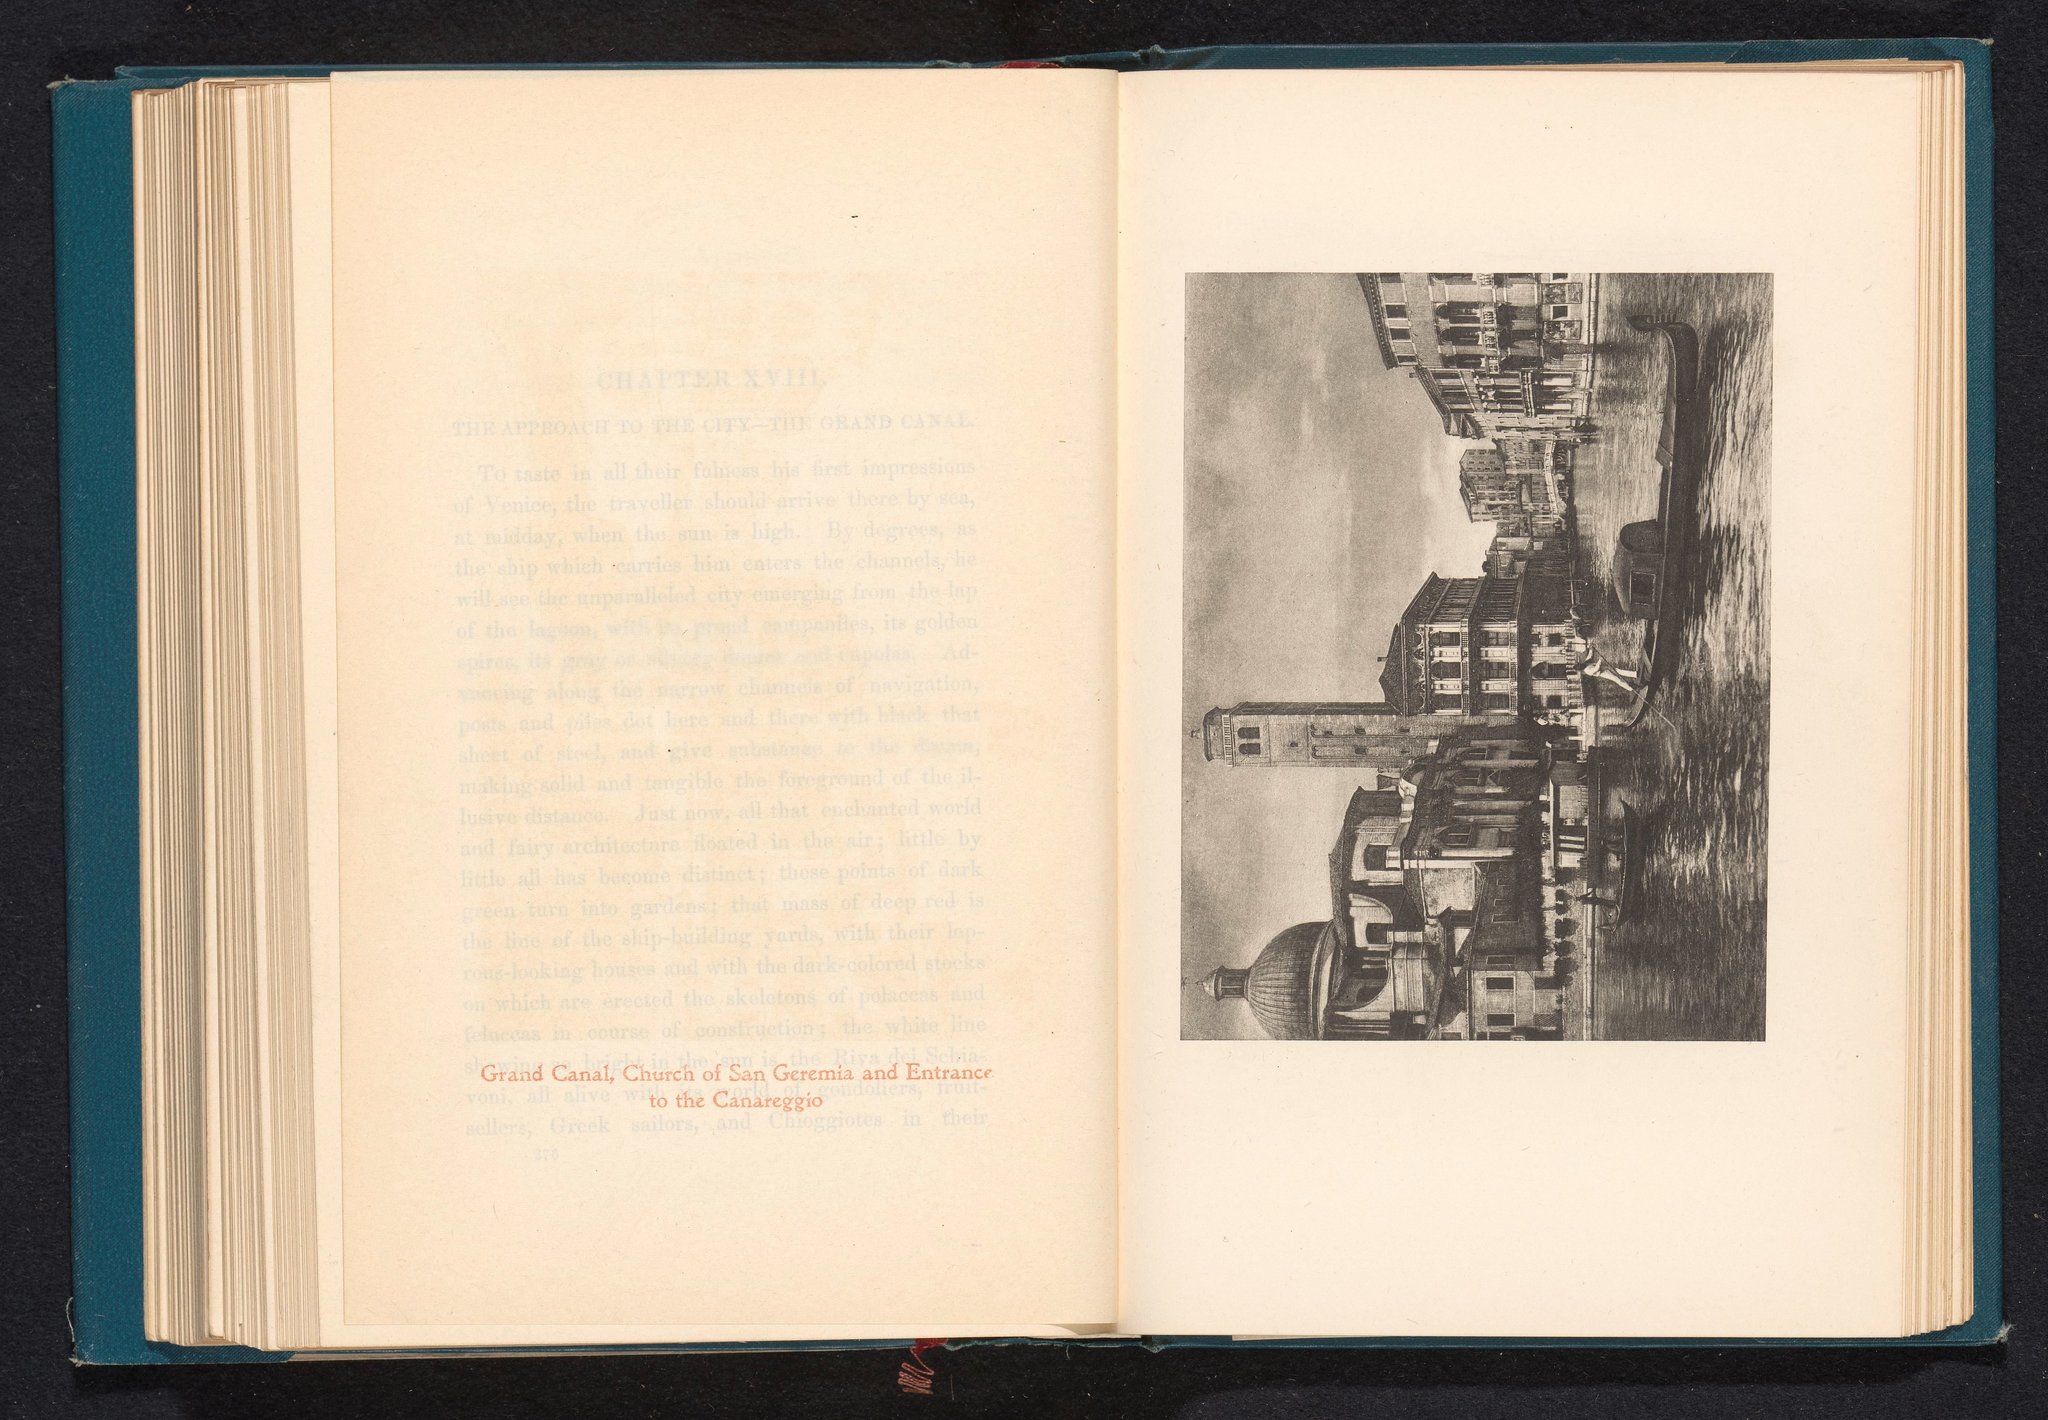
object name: photomechanical print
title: Fotoreproductie van een prent, voorstellende een gezicht op het Canal Grande te Venetië, met op de achtergrond de San Geremia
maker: Anonymous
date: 1882-1892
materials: paper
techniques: photoaquatint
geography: venice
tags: church (exterior), canals, waters (in city)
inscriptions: title: ‘Grand Canal, Church of San Geremia and entrance to the Canareggio’